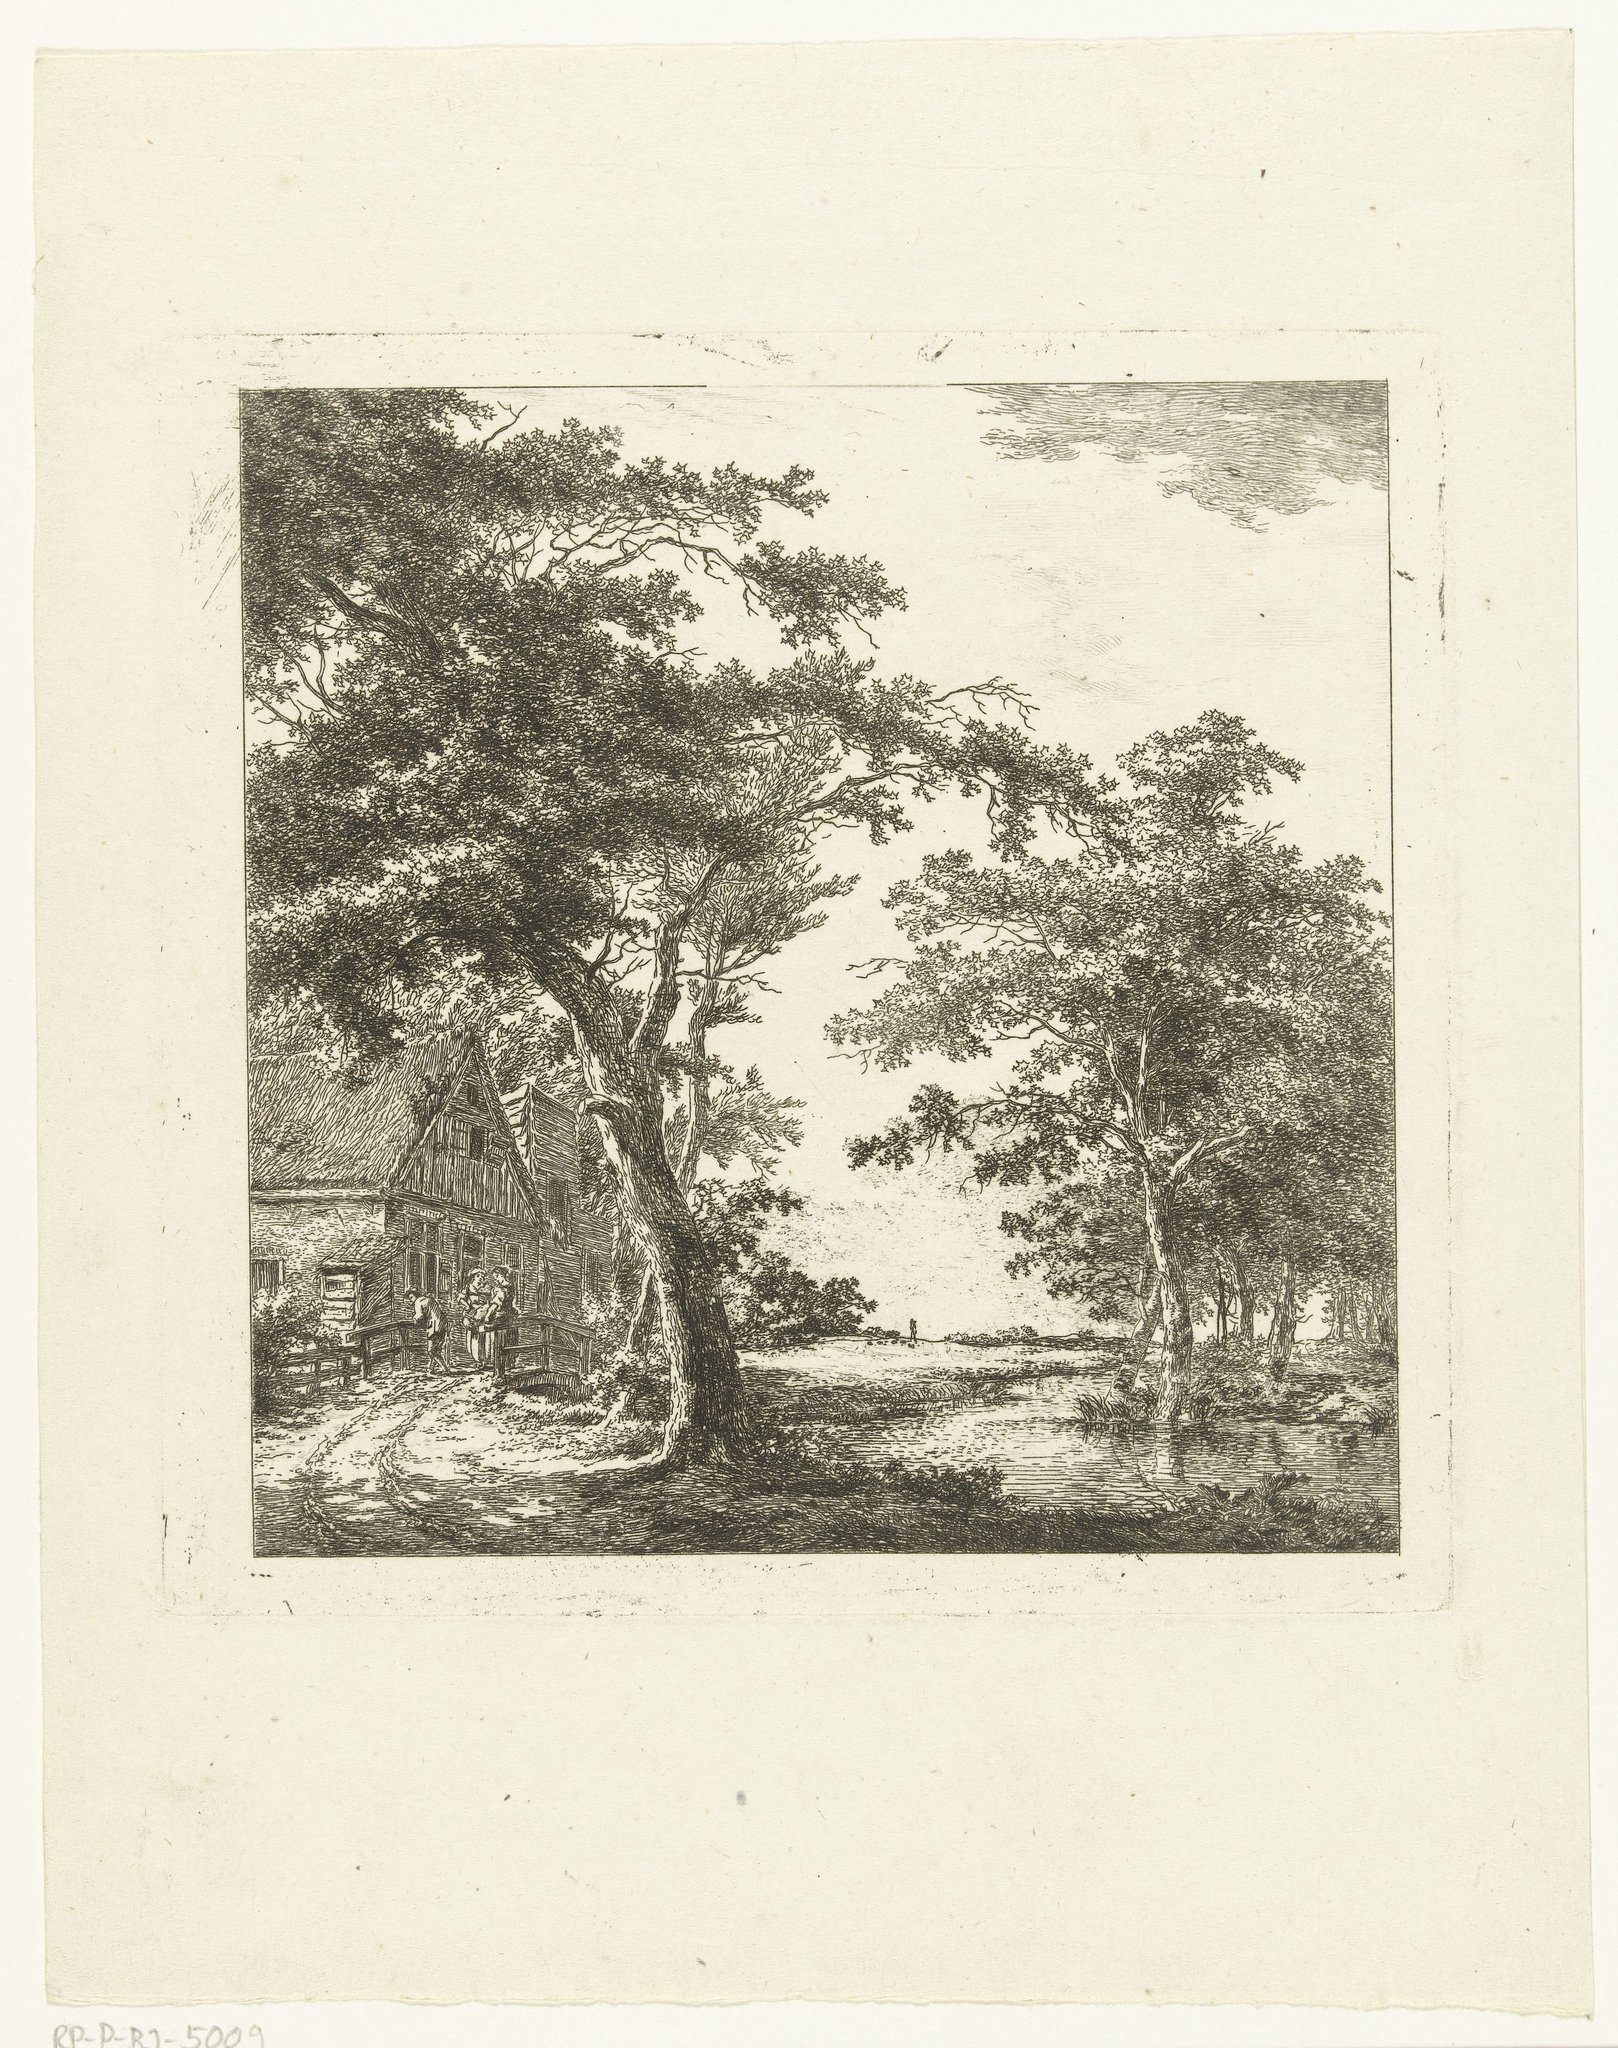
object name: print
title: Drie figuren op een bruggetje voor een huis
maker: hermanus van brussel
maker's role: draughtsman, print maker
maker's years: 1763-1815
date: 1800-1815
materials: paper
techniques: etching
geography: netherlands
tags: landscapes in the temperate zone, landscapes with waters, waterscapes, seascapes (in the temperate zone)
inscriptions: collector's mark: Lugt 2228